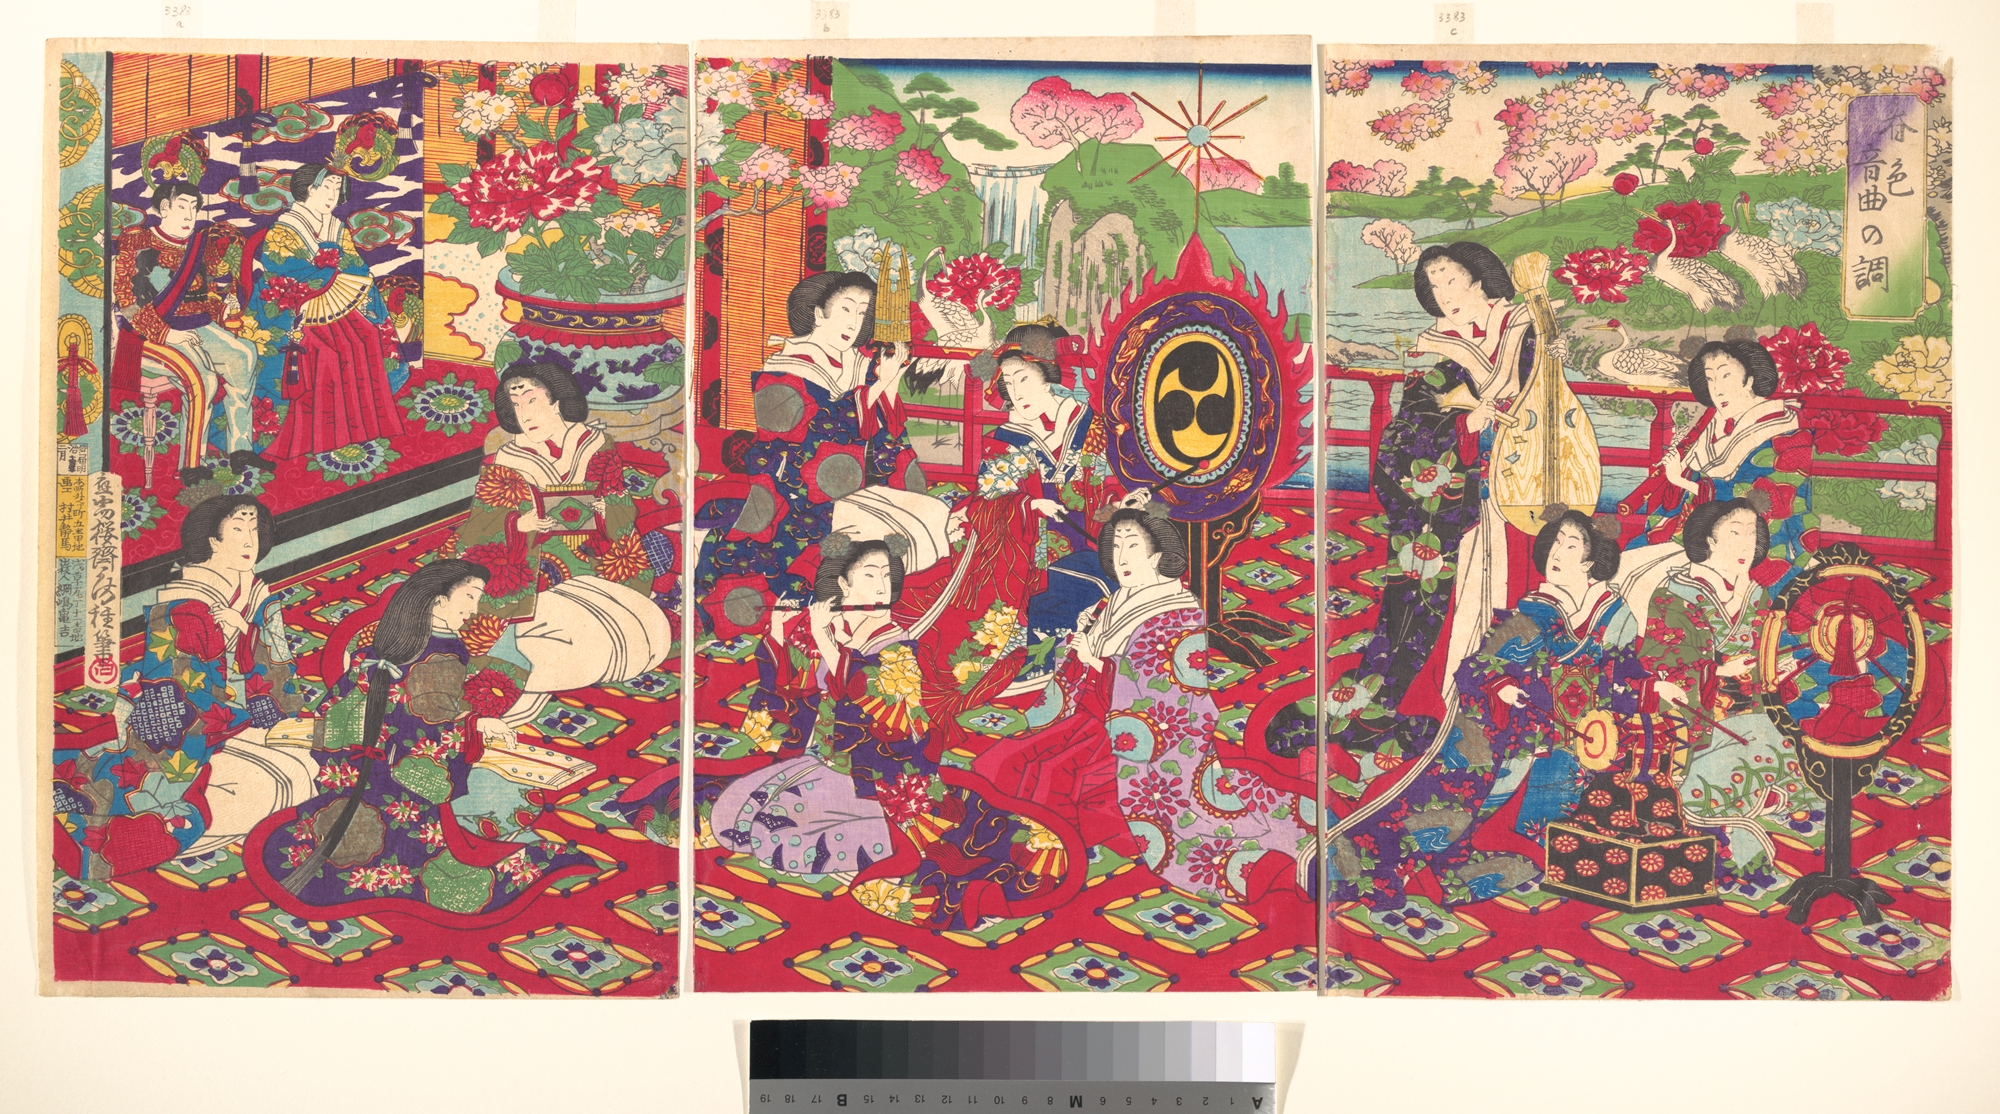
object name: print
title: Spring Scenery; Melody of a Musical Performance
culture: japanese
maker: utagawa fusatane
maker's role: artist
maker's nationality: japanese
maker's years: 1849-1880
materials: ink, paper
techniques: woodblock print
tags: performance,women,flowers